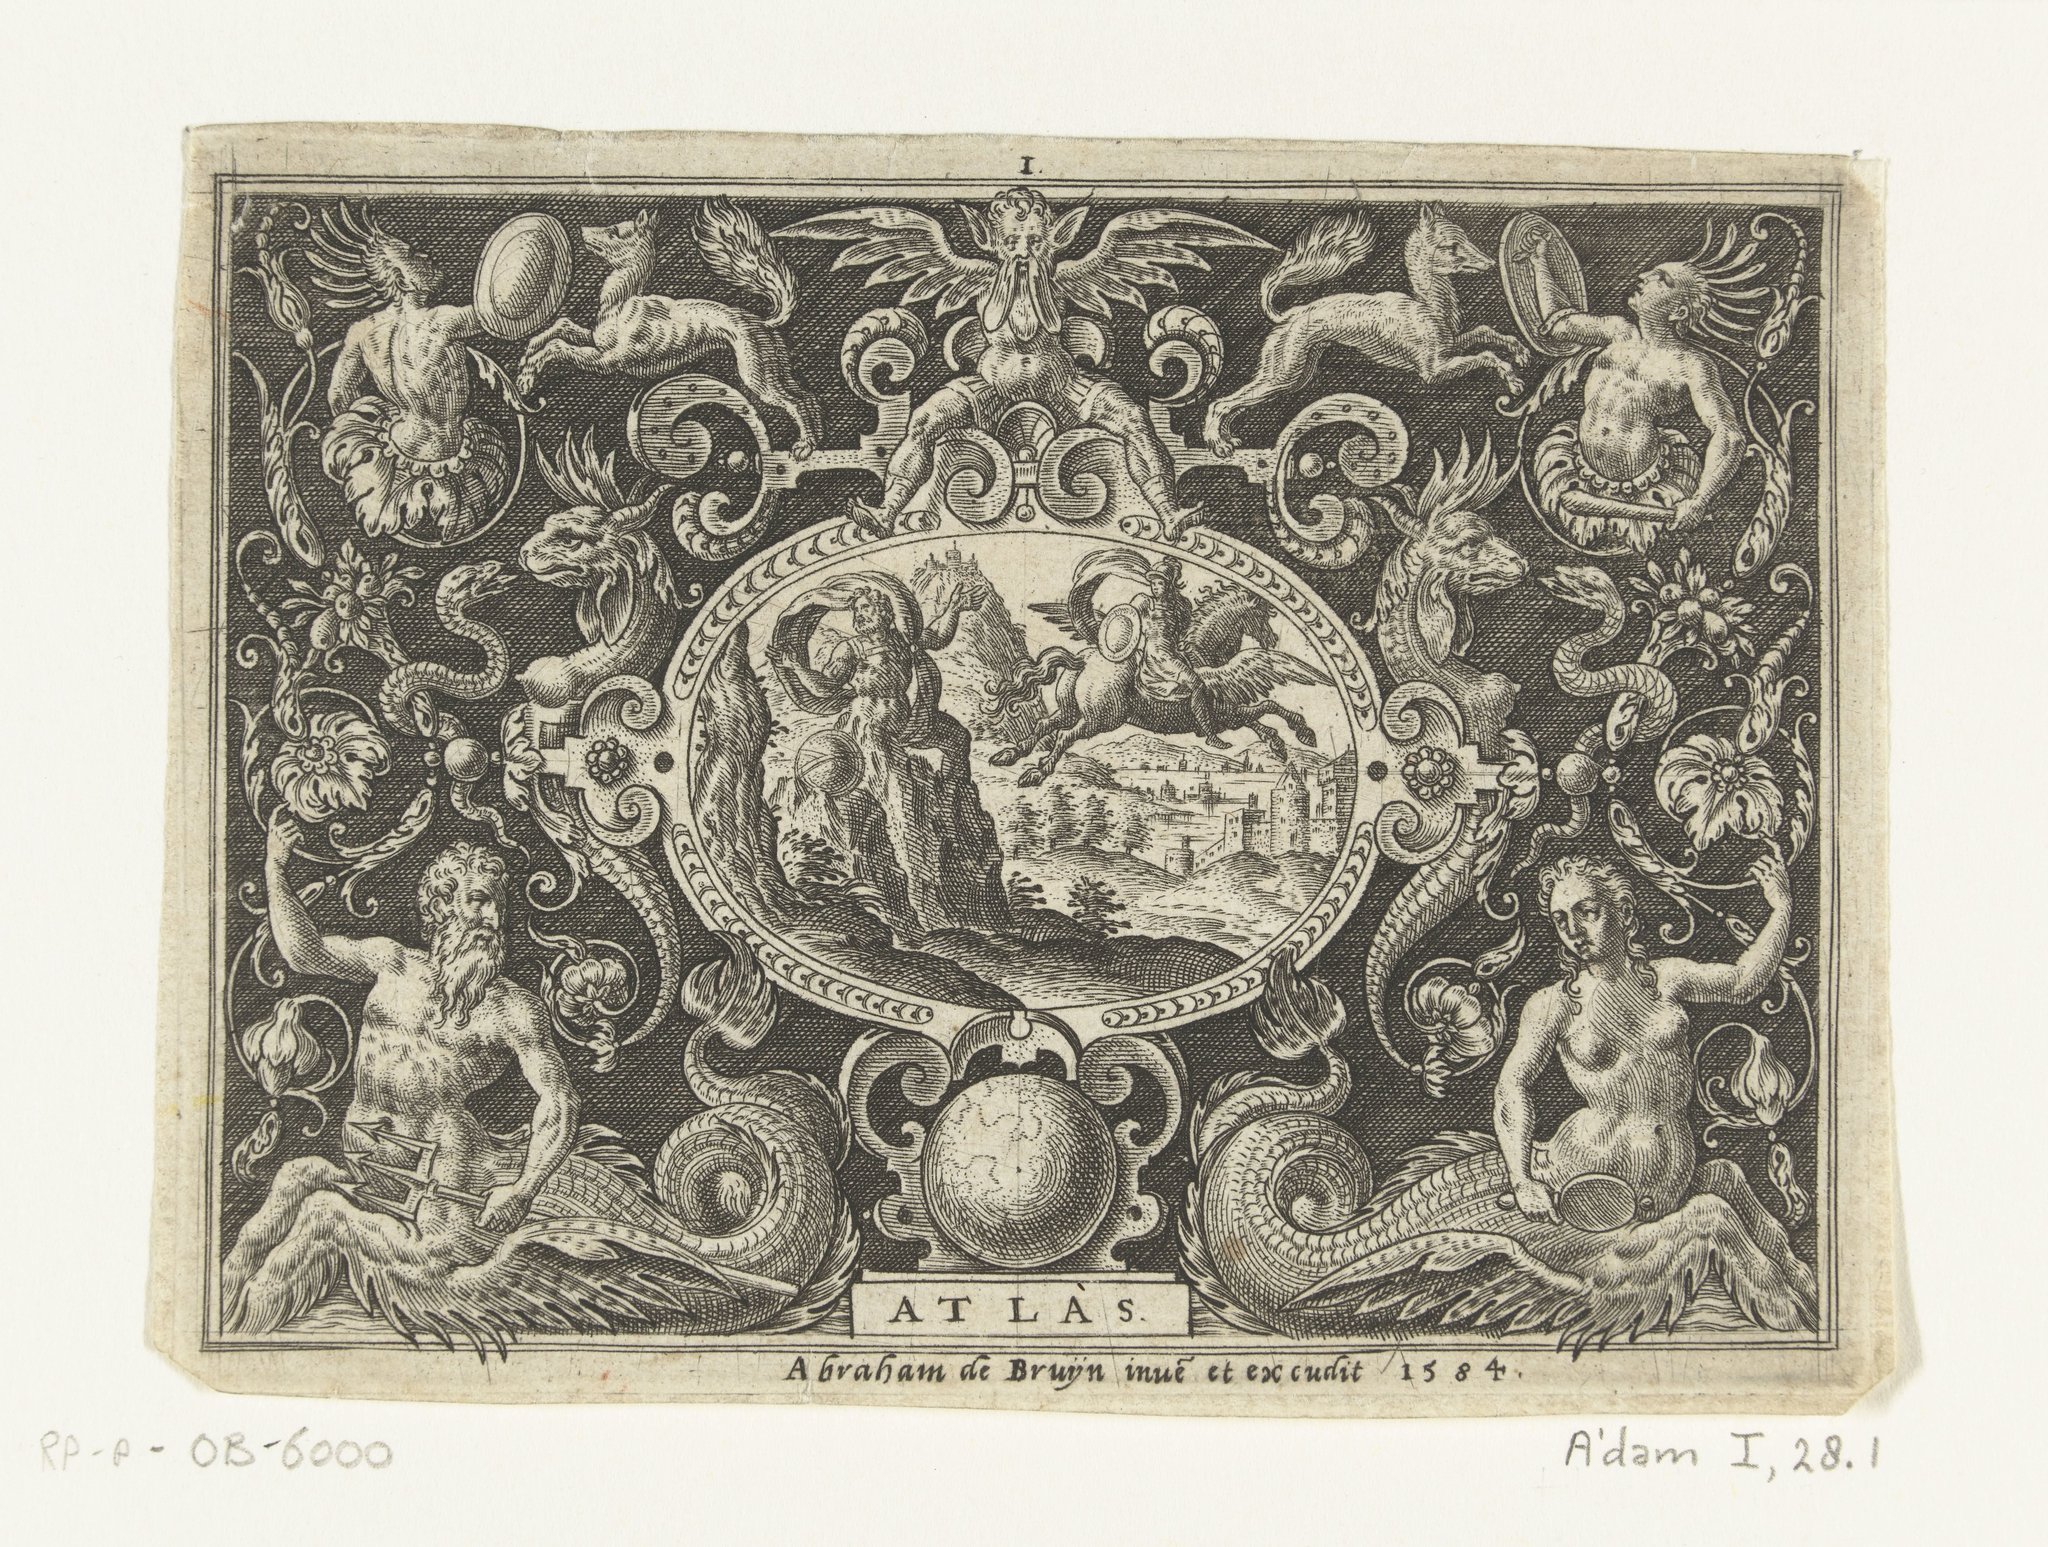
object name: print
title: Atlas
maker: abraham de bruyn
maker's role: print maker, publisher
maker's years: 1540-1587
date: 1584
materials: paper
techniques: engraving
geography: netherlands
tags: ornament ~ grotesque, triton(s), atlas turned into a mountain as punishment for his inhospitality, animals (+ symmetrically placed ornamental animals), ornament ~ cartouche, other nereids (or sea-nymphs)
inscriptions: number: ‘I’, title: ‘ATLAS’, address: ‘Abraham de Bruyn inve et excudit’, date: ‘1584’, title: ‘ATLAS’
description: Perseus bij Atlas die in een berg verandert. Het cartouche is gevat in een ornamentomlijsting met grotesken tegen een gearceerde achtergrond. Linksonder en rechtsonder een triton en een nereïde met gehoefde voorpoten.